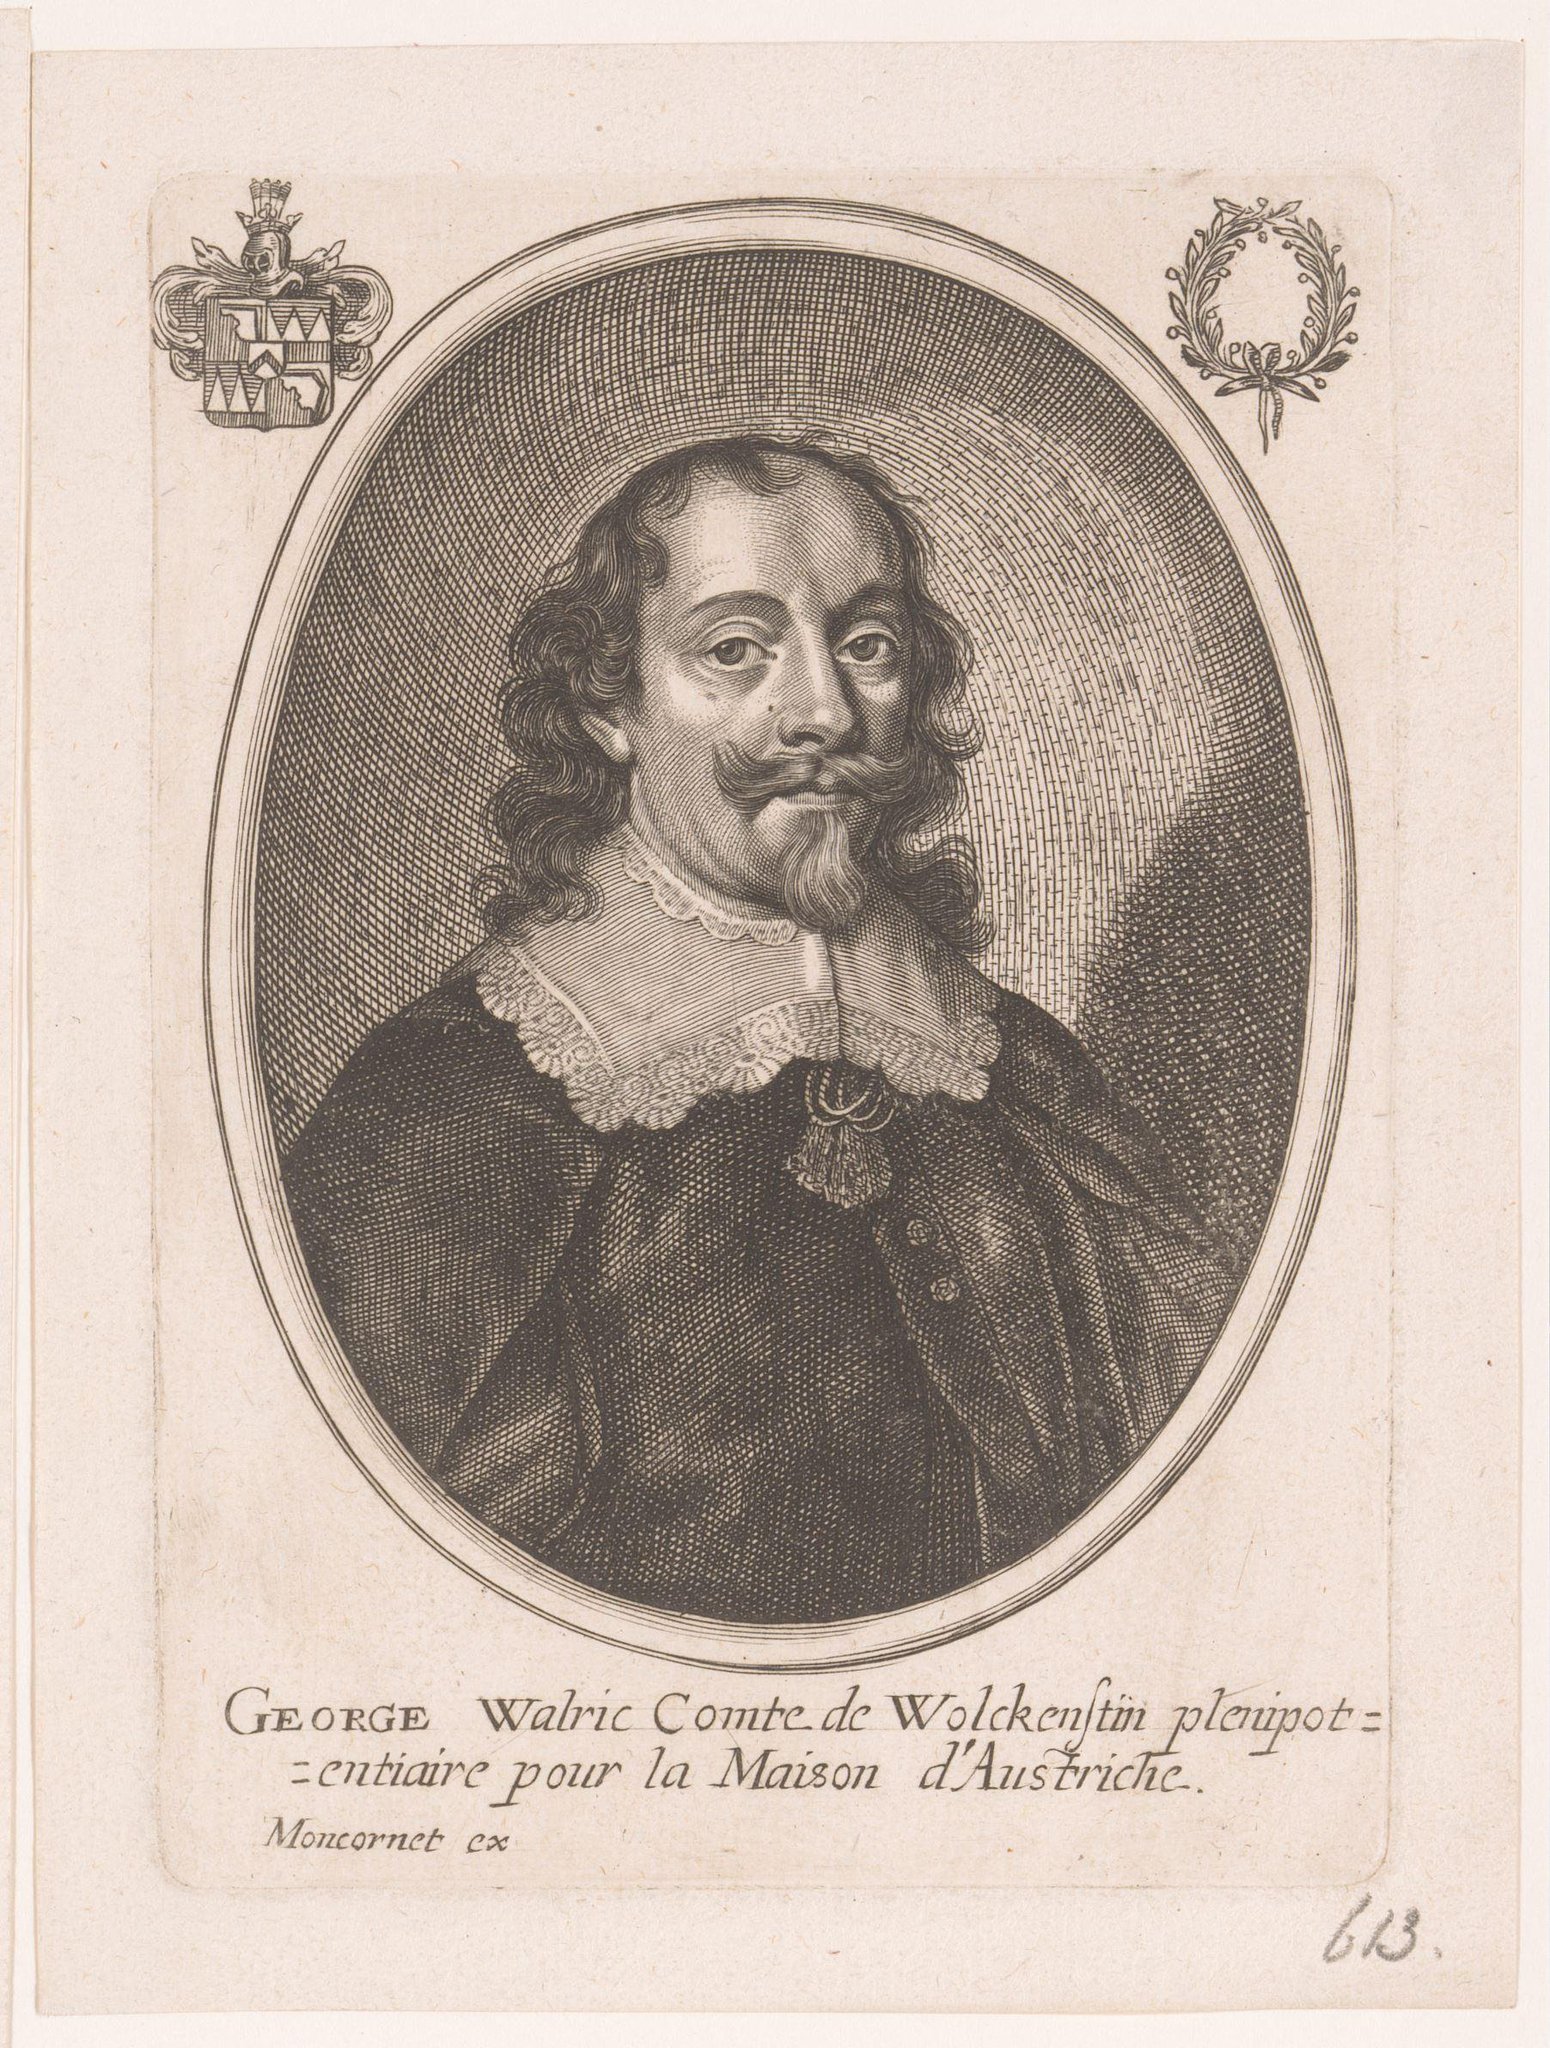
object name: print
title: Portret van Georg Ulrich von Wolckenstein und Rodenegg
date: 1610-1668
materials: paper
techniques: engraving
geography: paris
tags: historical persons, armorial bearing, heraldry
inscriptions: collector's mark: Lugt 2228